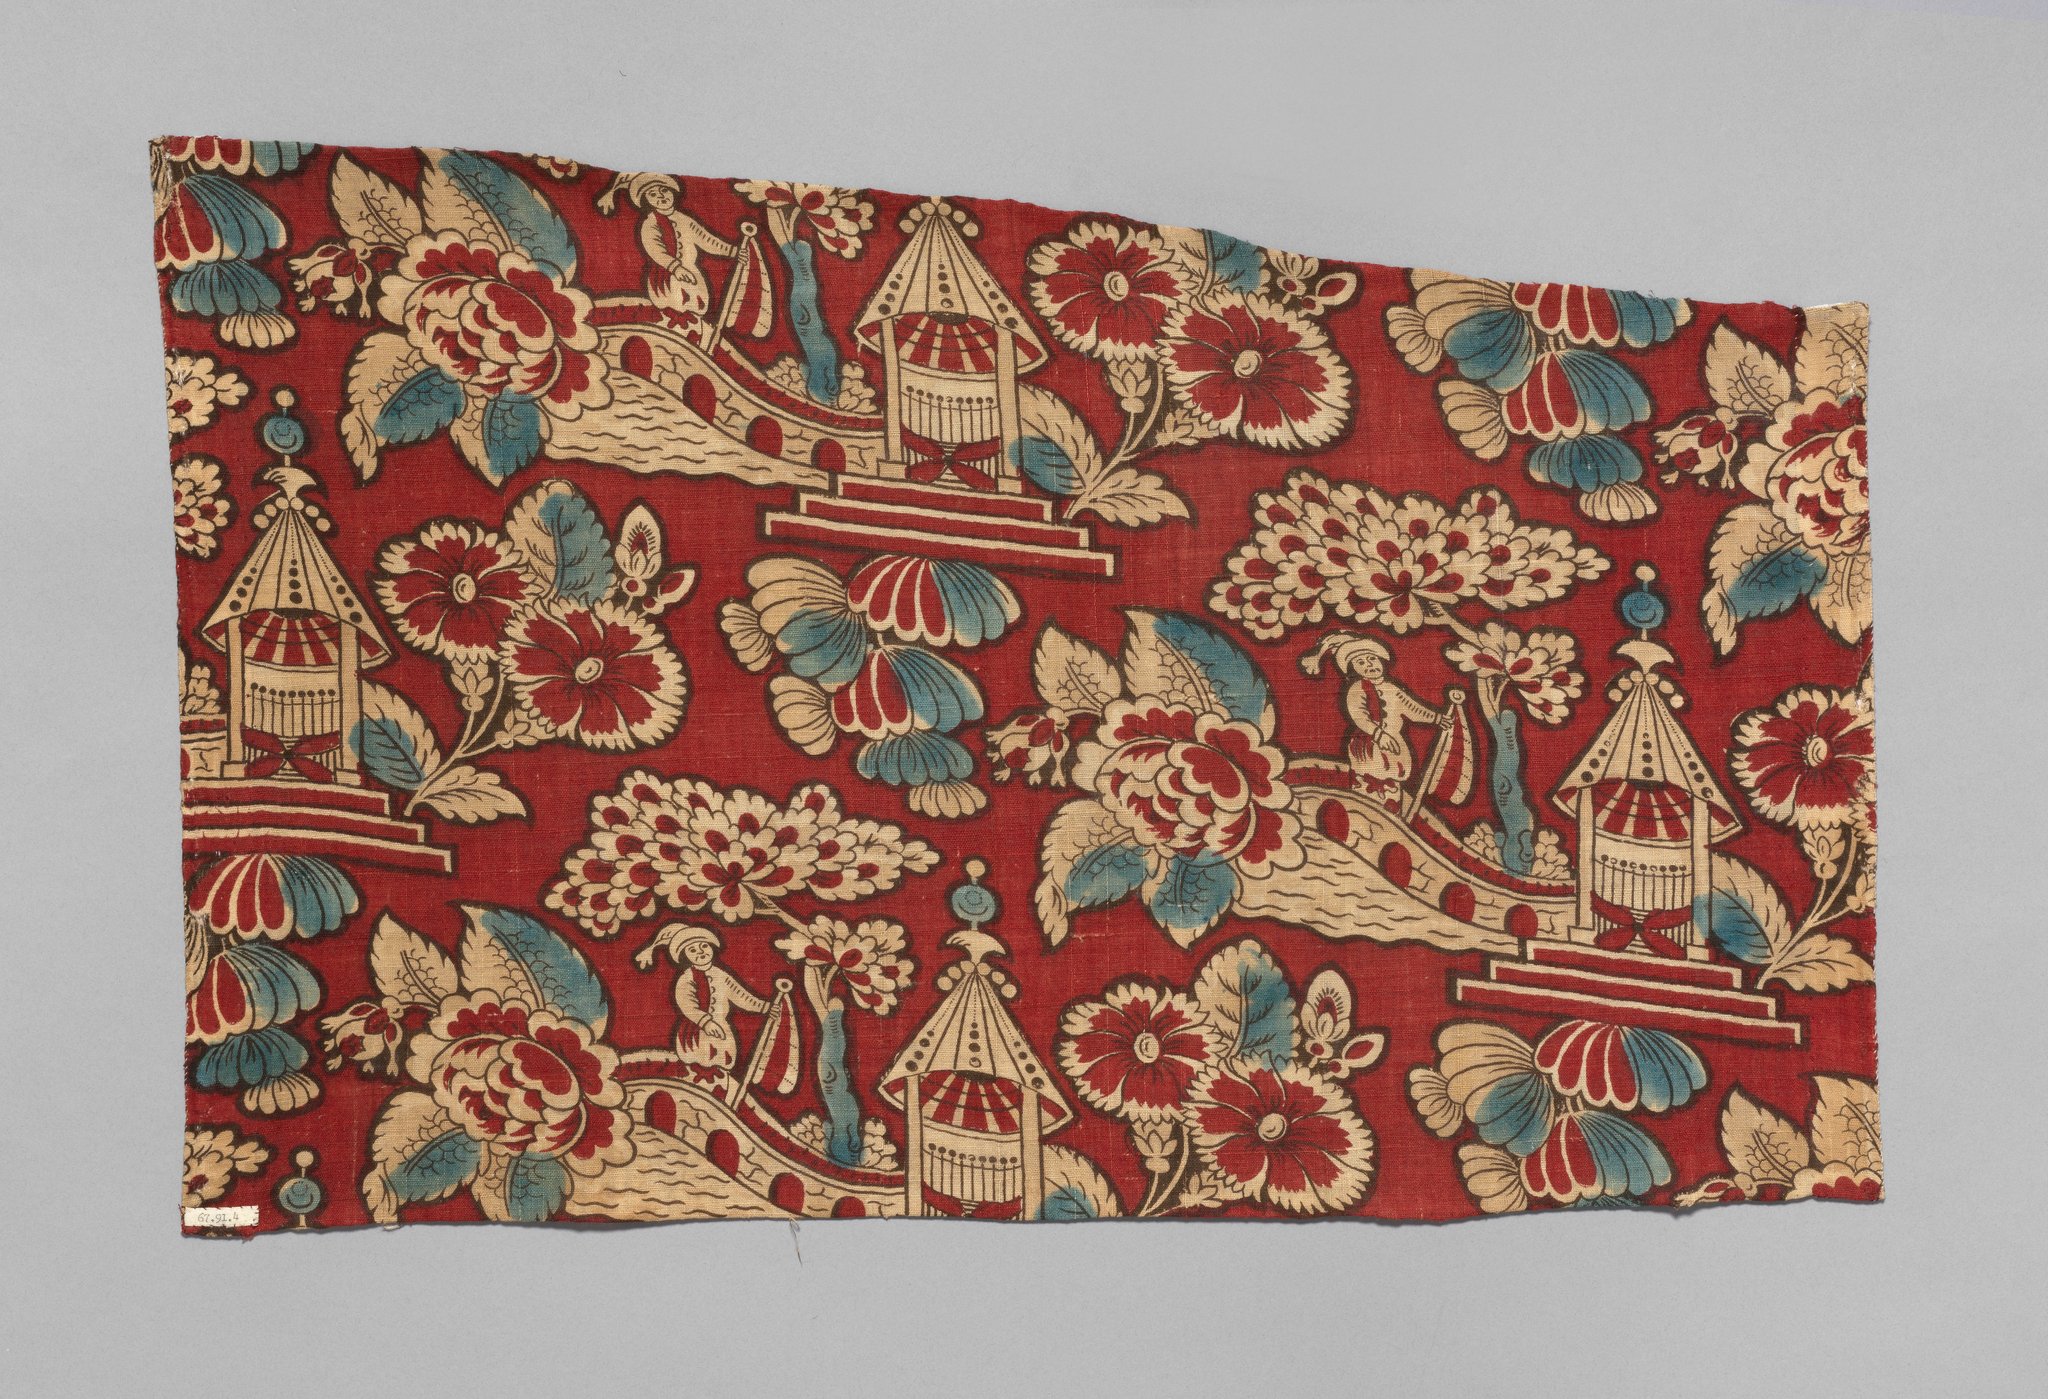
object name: piece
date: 1805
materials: cotton